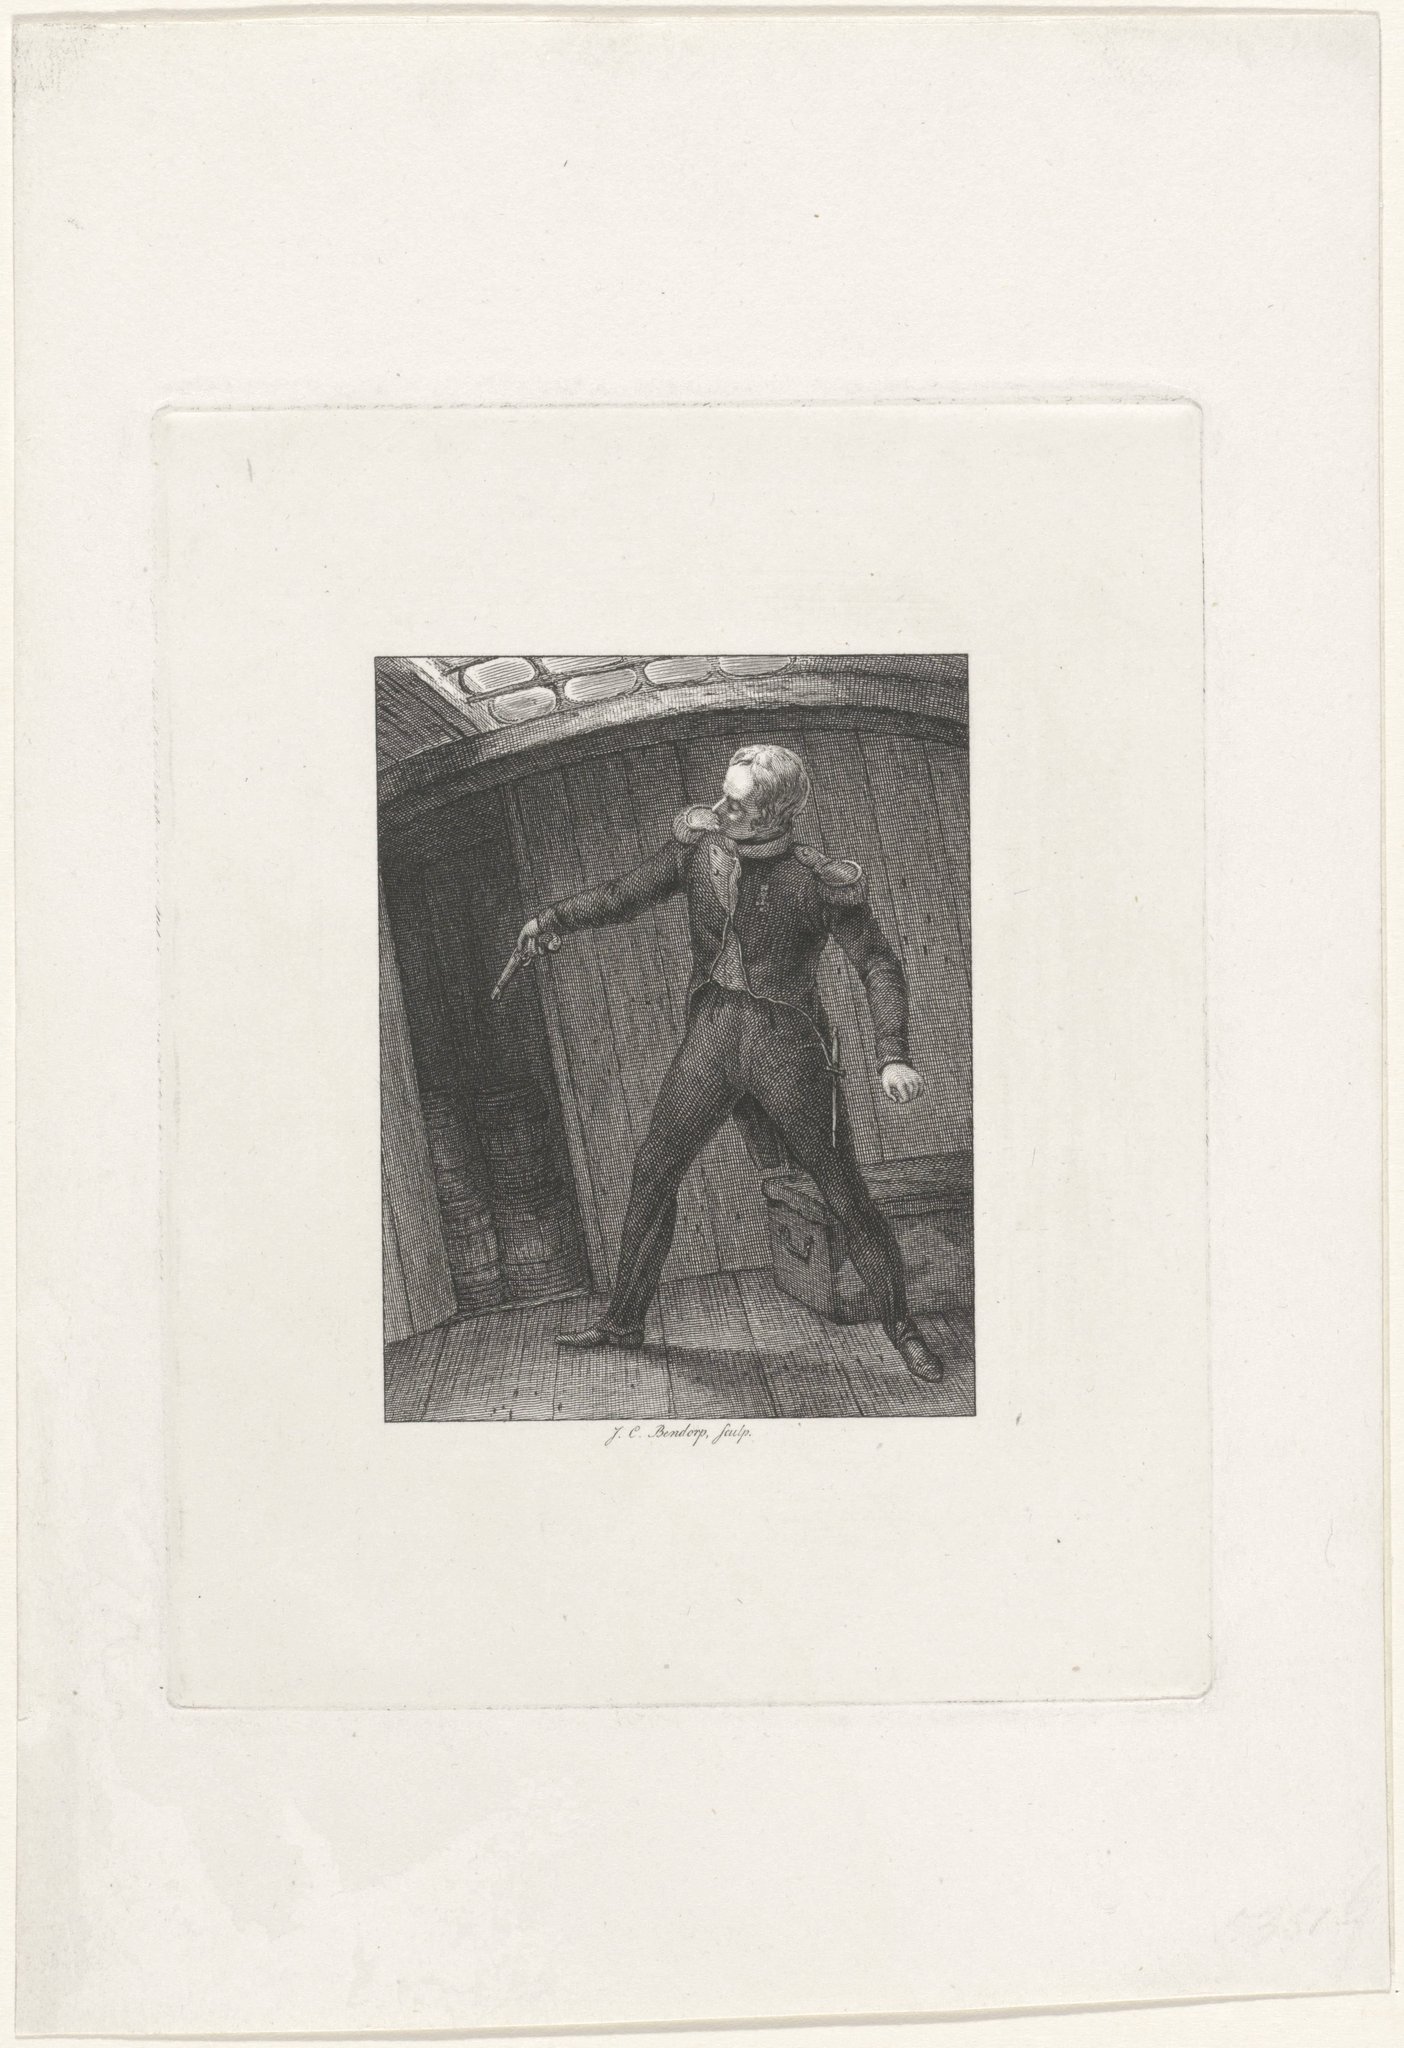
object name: history print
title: Jan van Speyk de brand in het kruit schietend, 1831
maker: johannes christiaan bendorp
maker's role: print maker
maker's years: 1766-1849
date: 1837-1838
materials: paper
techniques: engraving, etching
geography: netherlands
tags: amsterdam, antwerp, jan van speyk, navy (+ sailing-ships)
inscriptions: collector's mark: Lugt 2228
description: Jan van Speyk schiet met zijn pistool in de voorraad kruit opgeslagen in de kajuitskamer, 5 februari 1831.